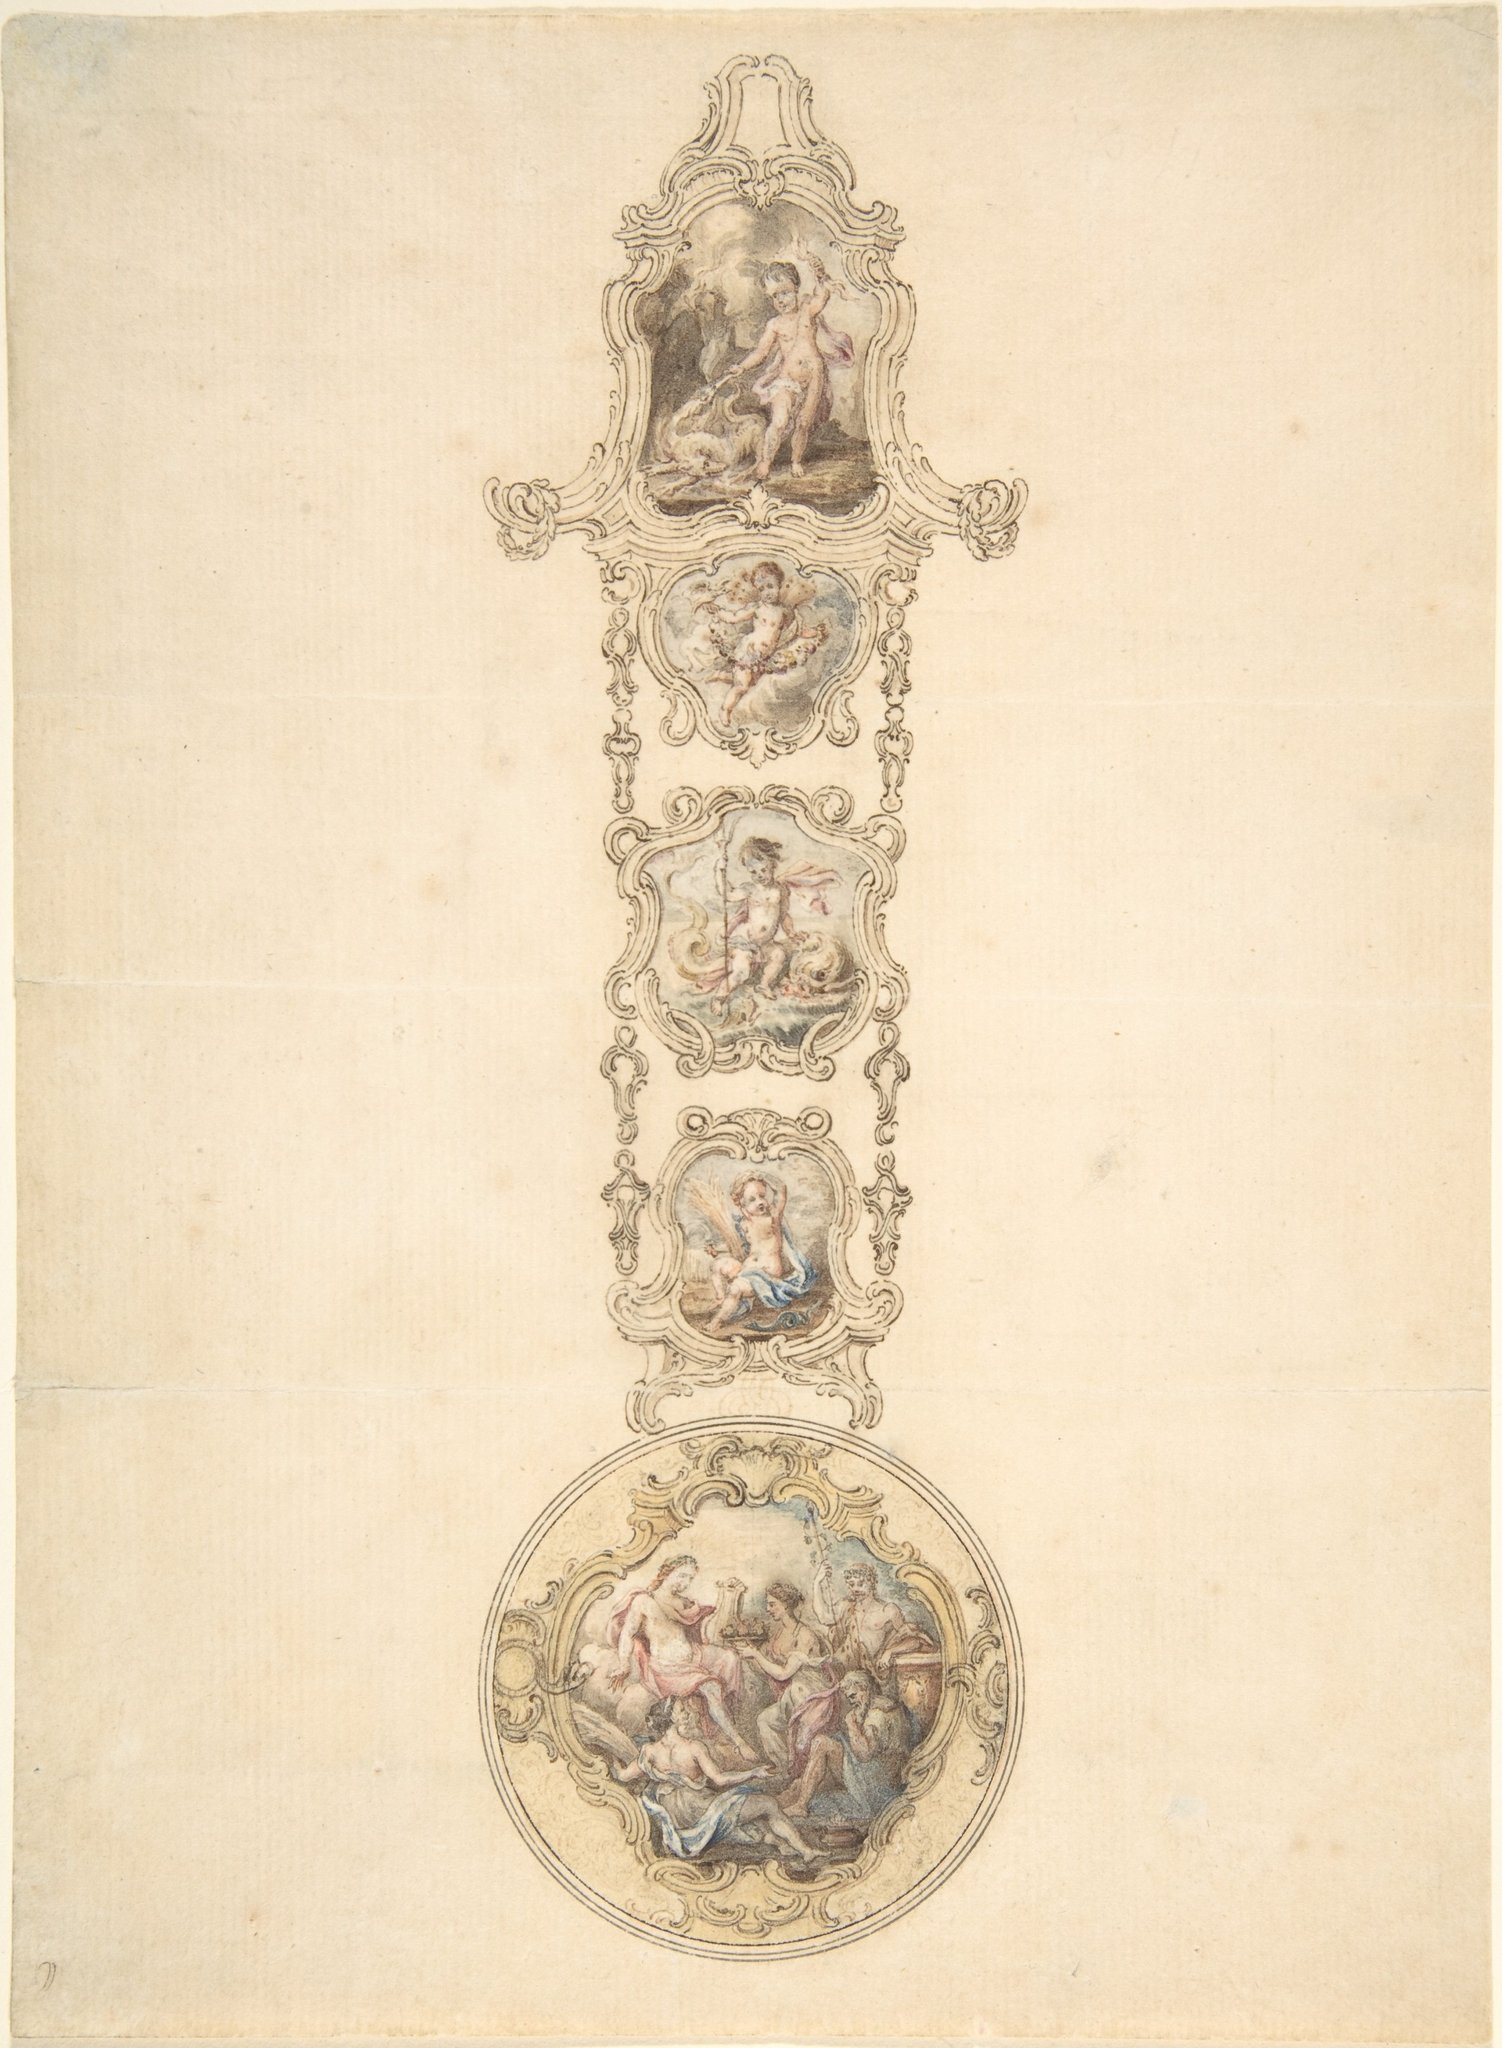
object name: drawing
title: Design for an Enameled Watchcase and Châtelaine with Mythological Figures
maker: george michael moser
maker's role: artist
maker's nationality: swiss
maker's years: 1706-1783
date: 1766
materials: gouache, ink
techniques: pen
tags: men,women,putti